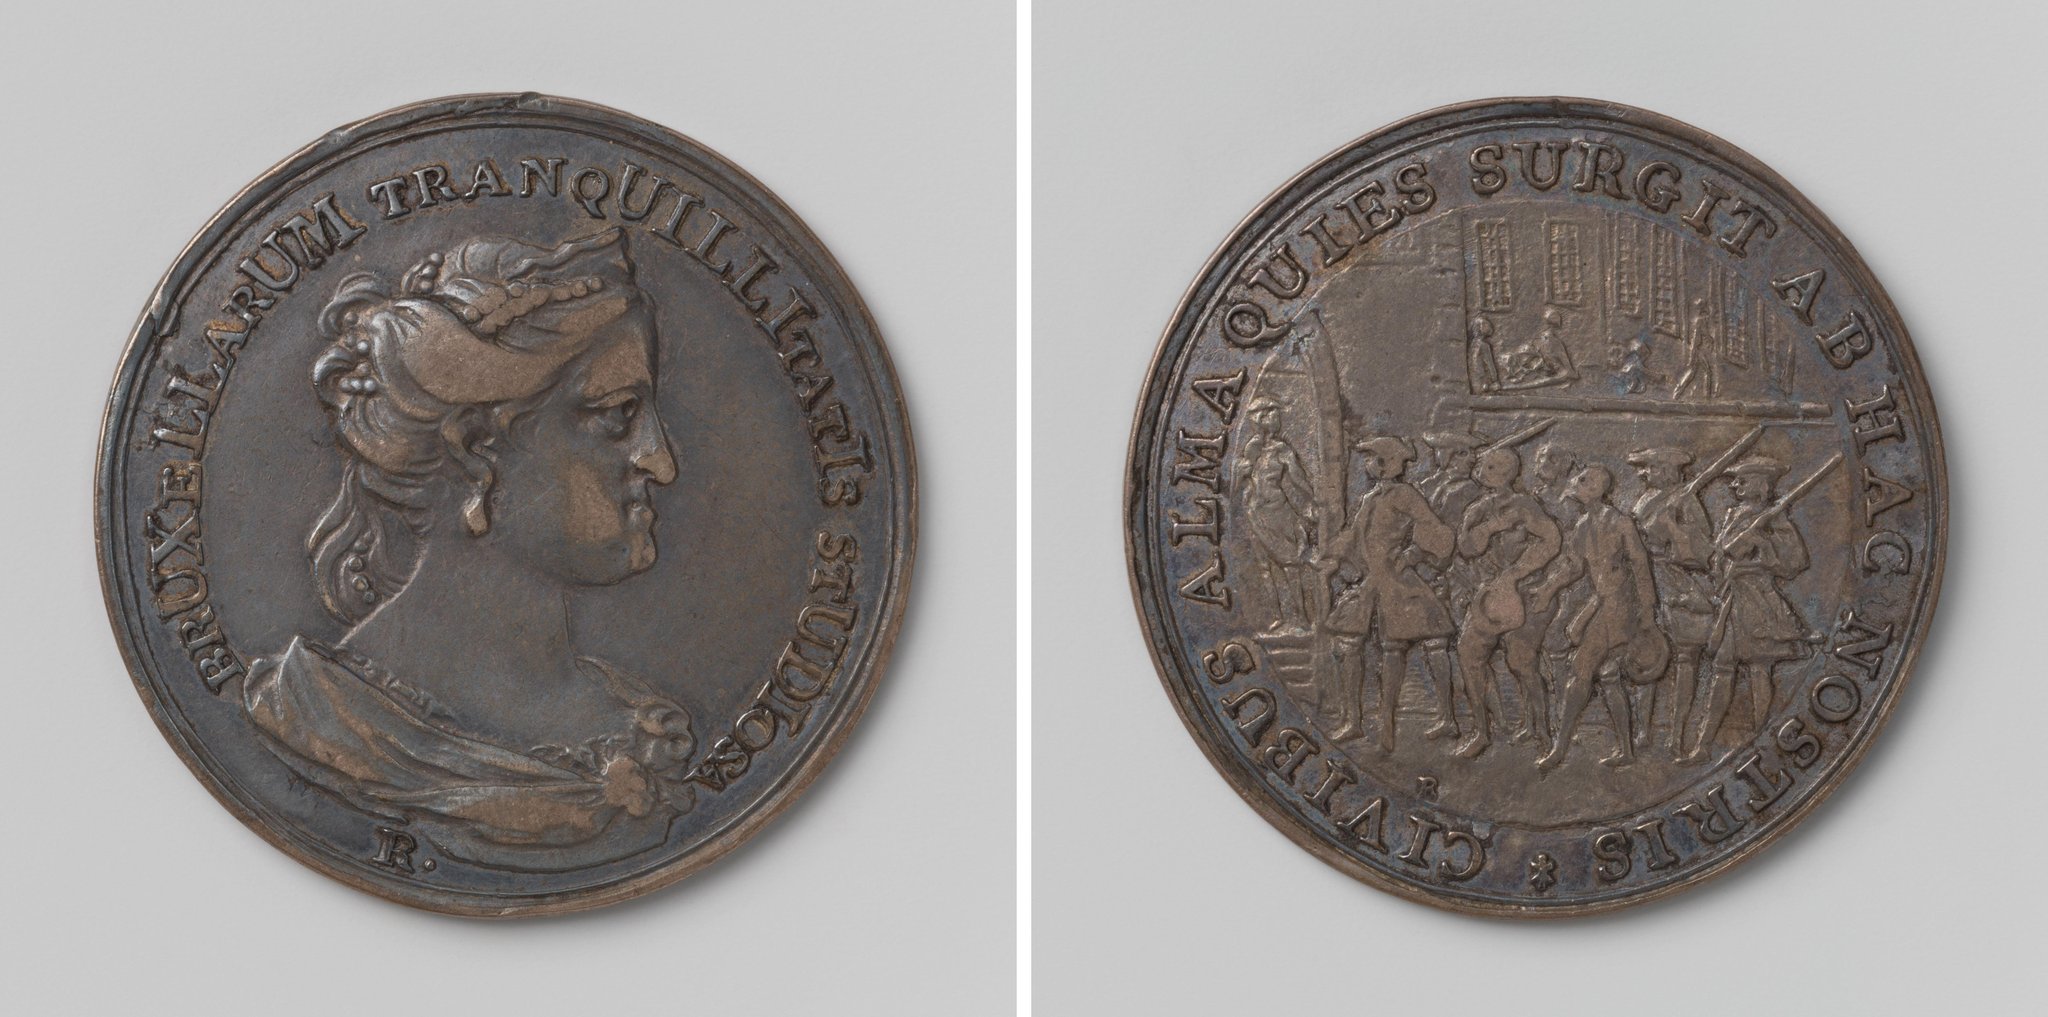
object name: new year medal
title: Stichting van een armenhuis te Brussel, rekenpenning geslagen ter ere van Maria Elisabeth, landvoogdes der zuidelijke Nederlanden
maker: jacques roëttiers (ii)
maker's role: medailleur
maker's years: 1698-1772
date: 1734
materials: silver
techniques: striking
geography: antwerp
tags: brussels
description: Zilveren penning. Voorzijde: borststuk vrouw met diadeem binnen omschrift. Keerzijde: patrouille voert drie bedelaars naar armenhuis; op binnenplaats van armenhuis: werkende mannen binnen omschrift